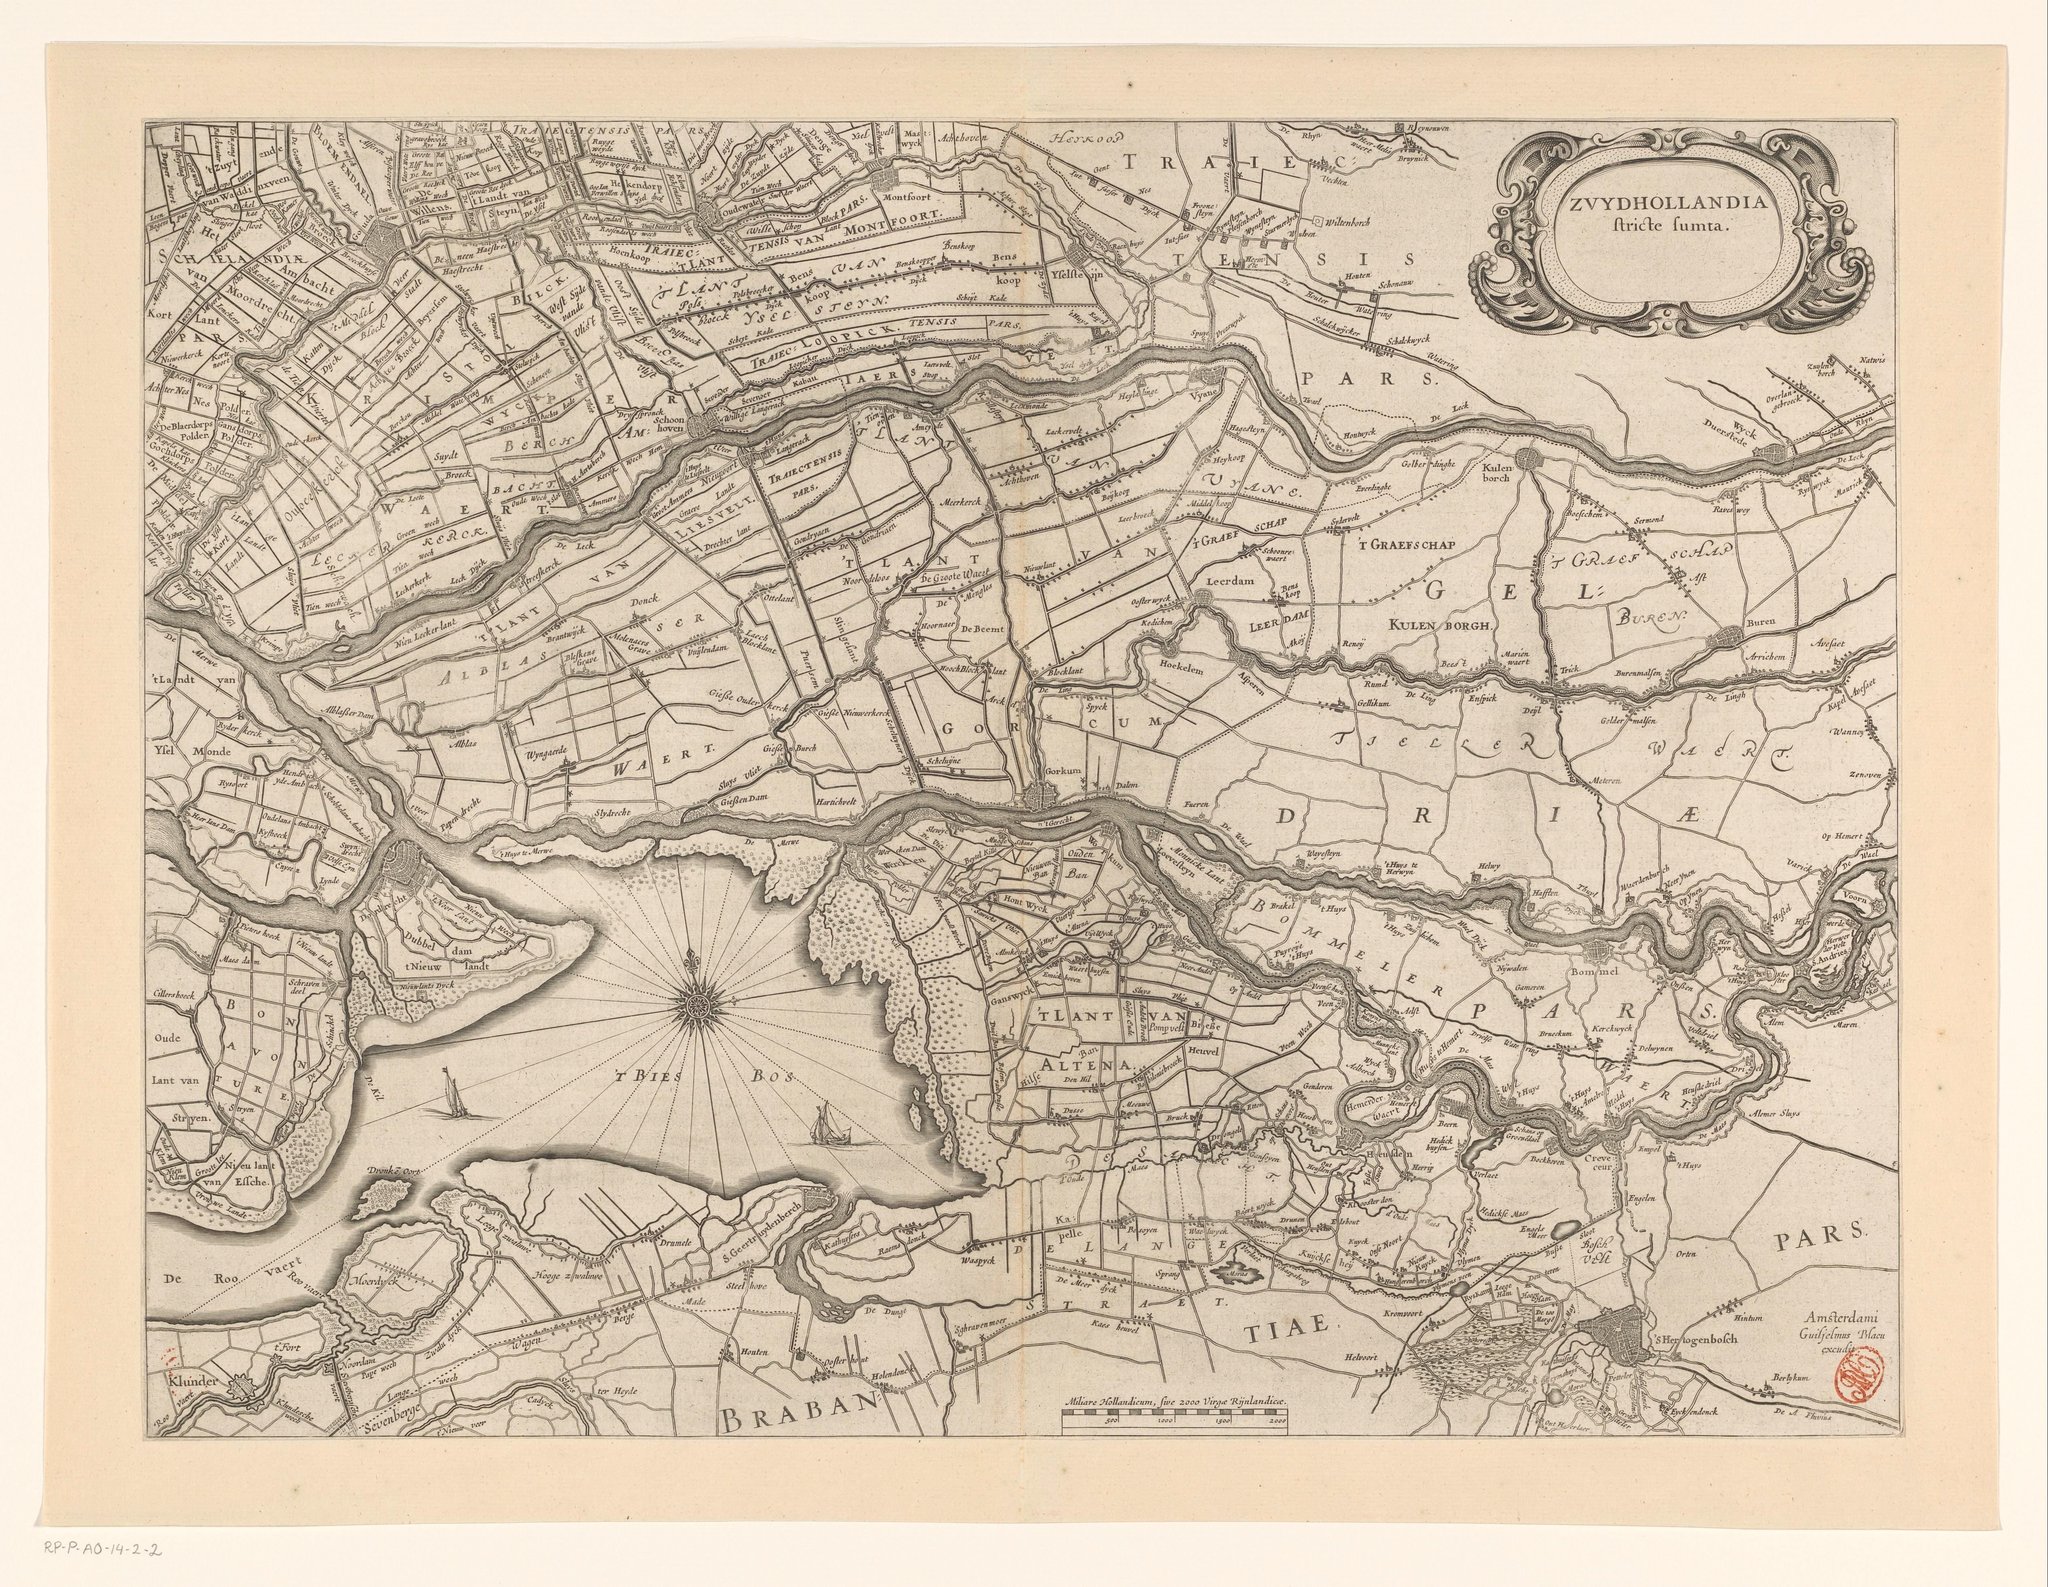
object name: print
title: Zuydhollandia stricte sumta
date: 1631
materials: paper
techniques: engraving, etching, letterpress printing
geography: amsterdam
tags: maps of separate countries or regions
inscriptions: collector's mark: Lugt 195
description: Kaart van een deel van Zuid-Holland rond de Biesbos. Onder rechts van het midden een schaalstok: Miliare Hollandicum, sive 2000 virgae Rijnlandicae. Rechtsboven de titelcartouche. Op verso Latijnse tekst.